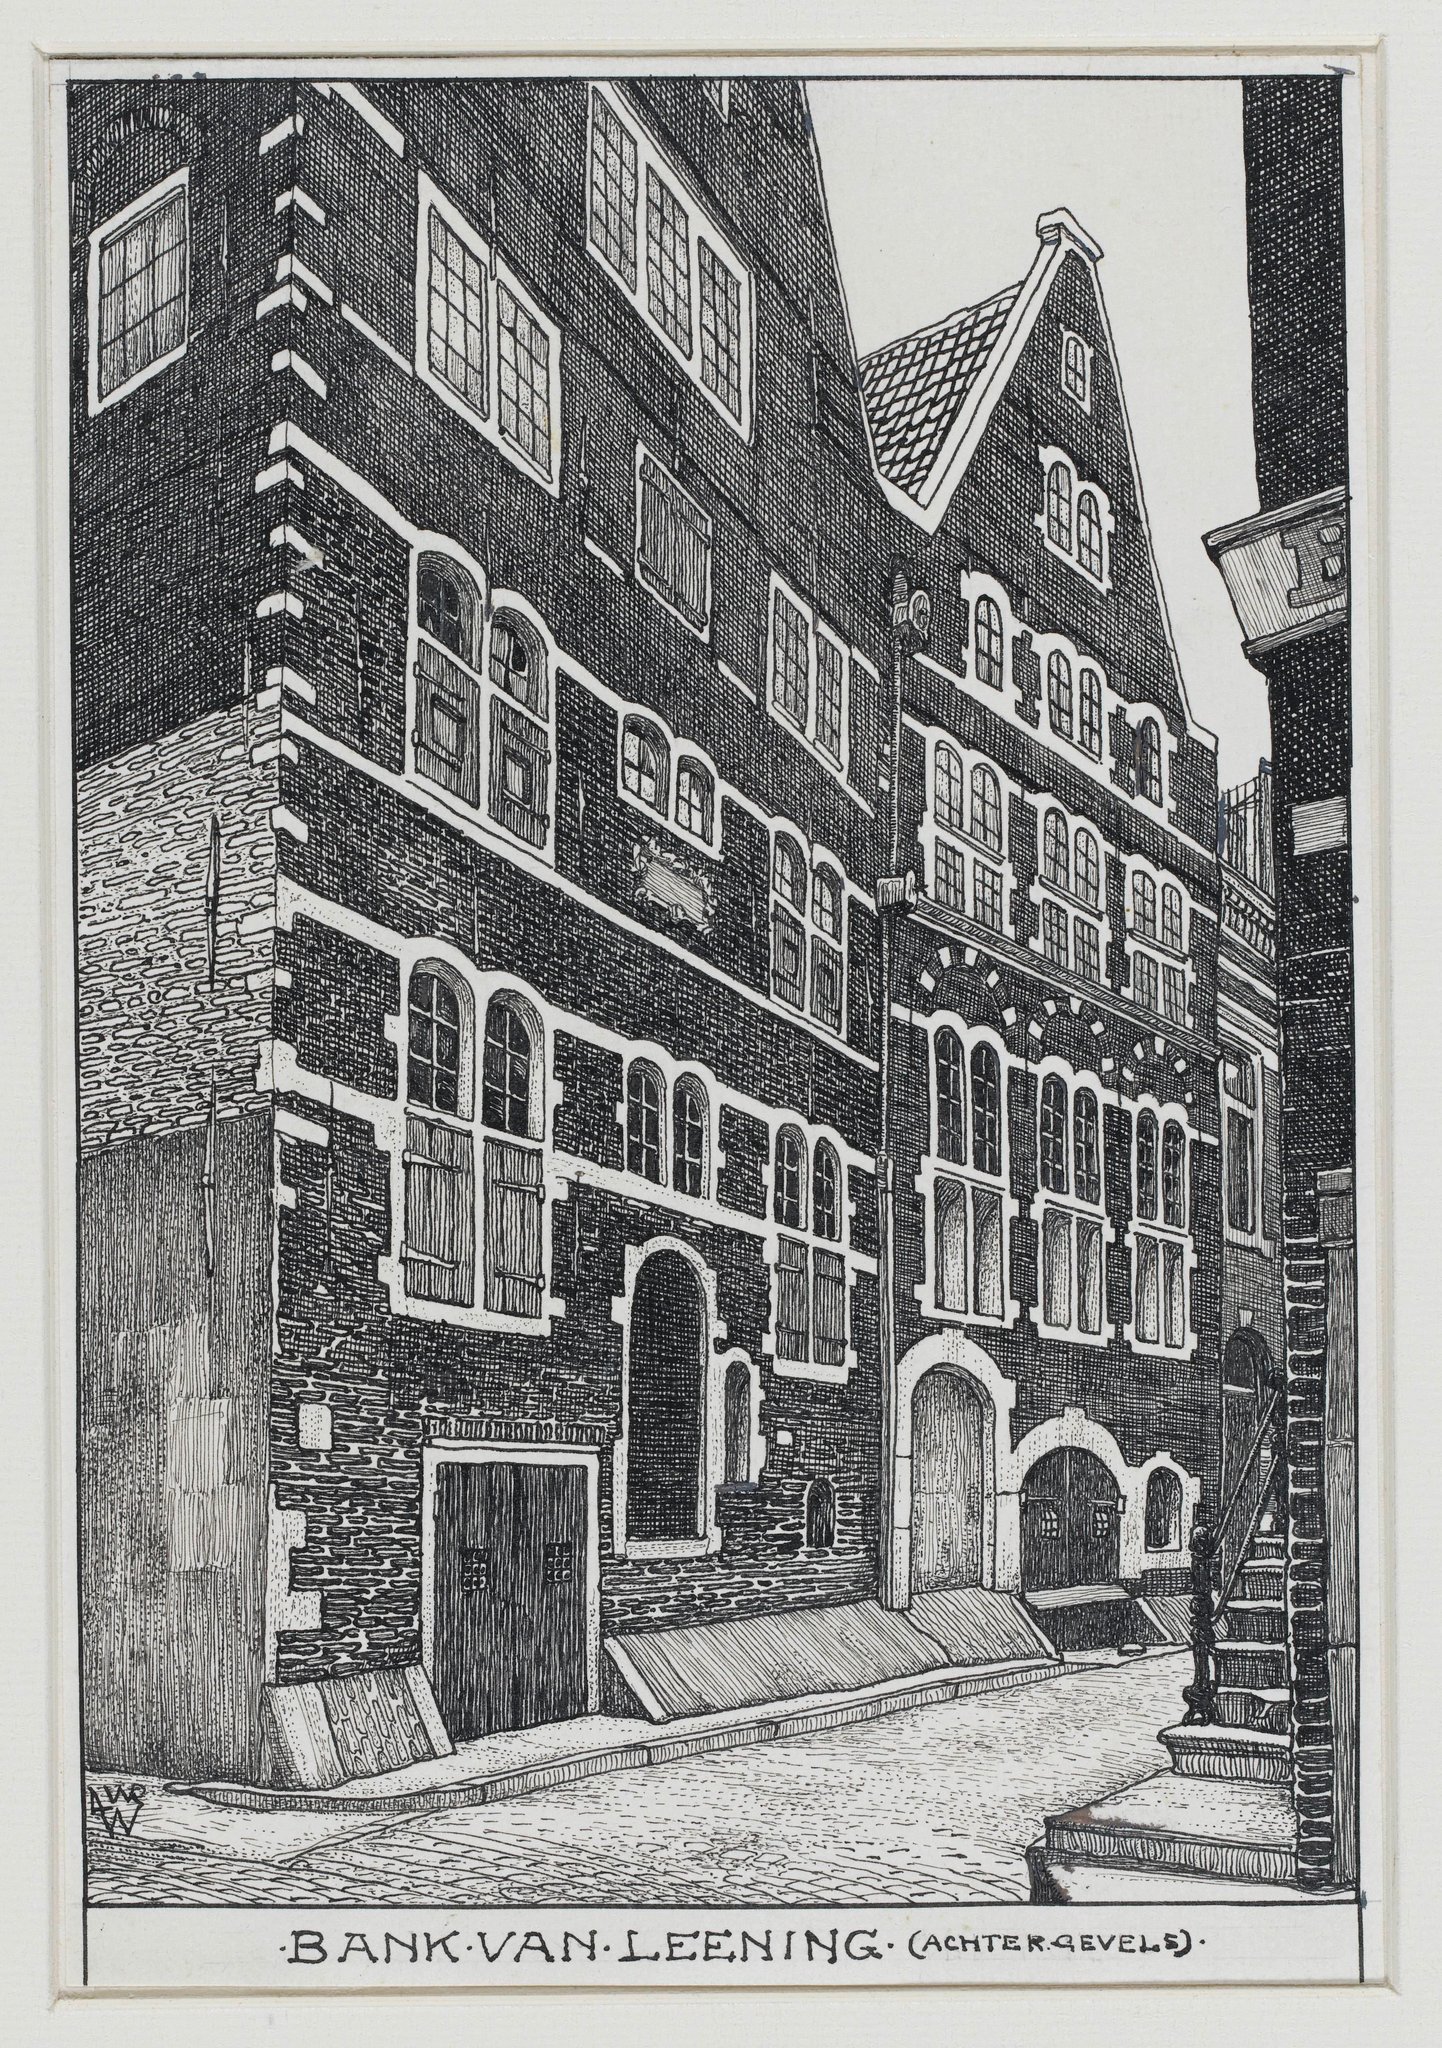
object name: drawing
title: Achtergevels van de Bank van Leening te Amsterdam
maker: willem wenckebach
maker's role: designer, draughtsman, painter, print maker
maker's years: 1860-1937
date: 1870-1926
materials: paint, ink, paper, pencil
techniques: pen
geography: amsterdam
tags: urban housing, amsterdam